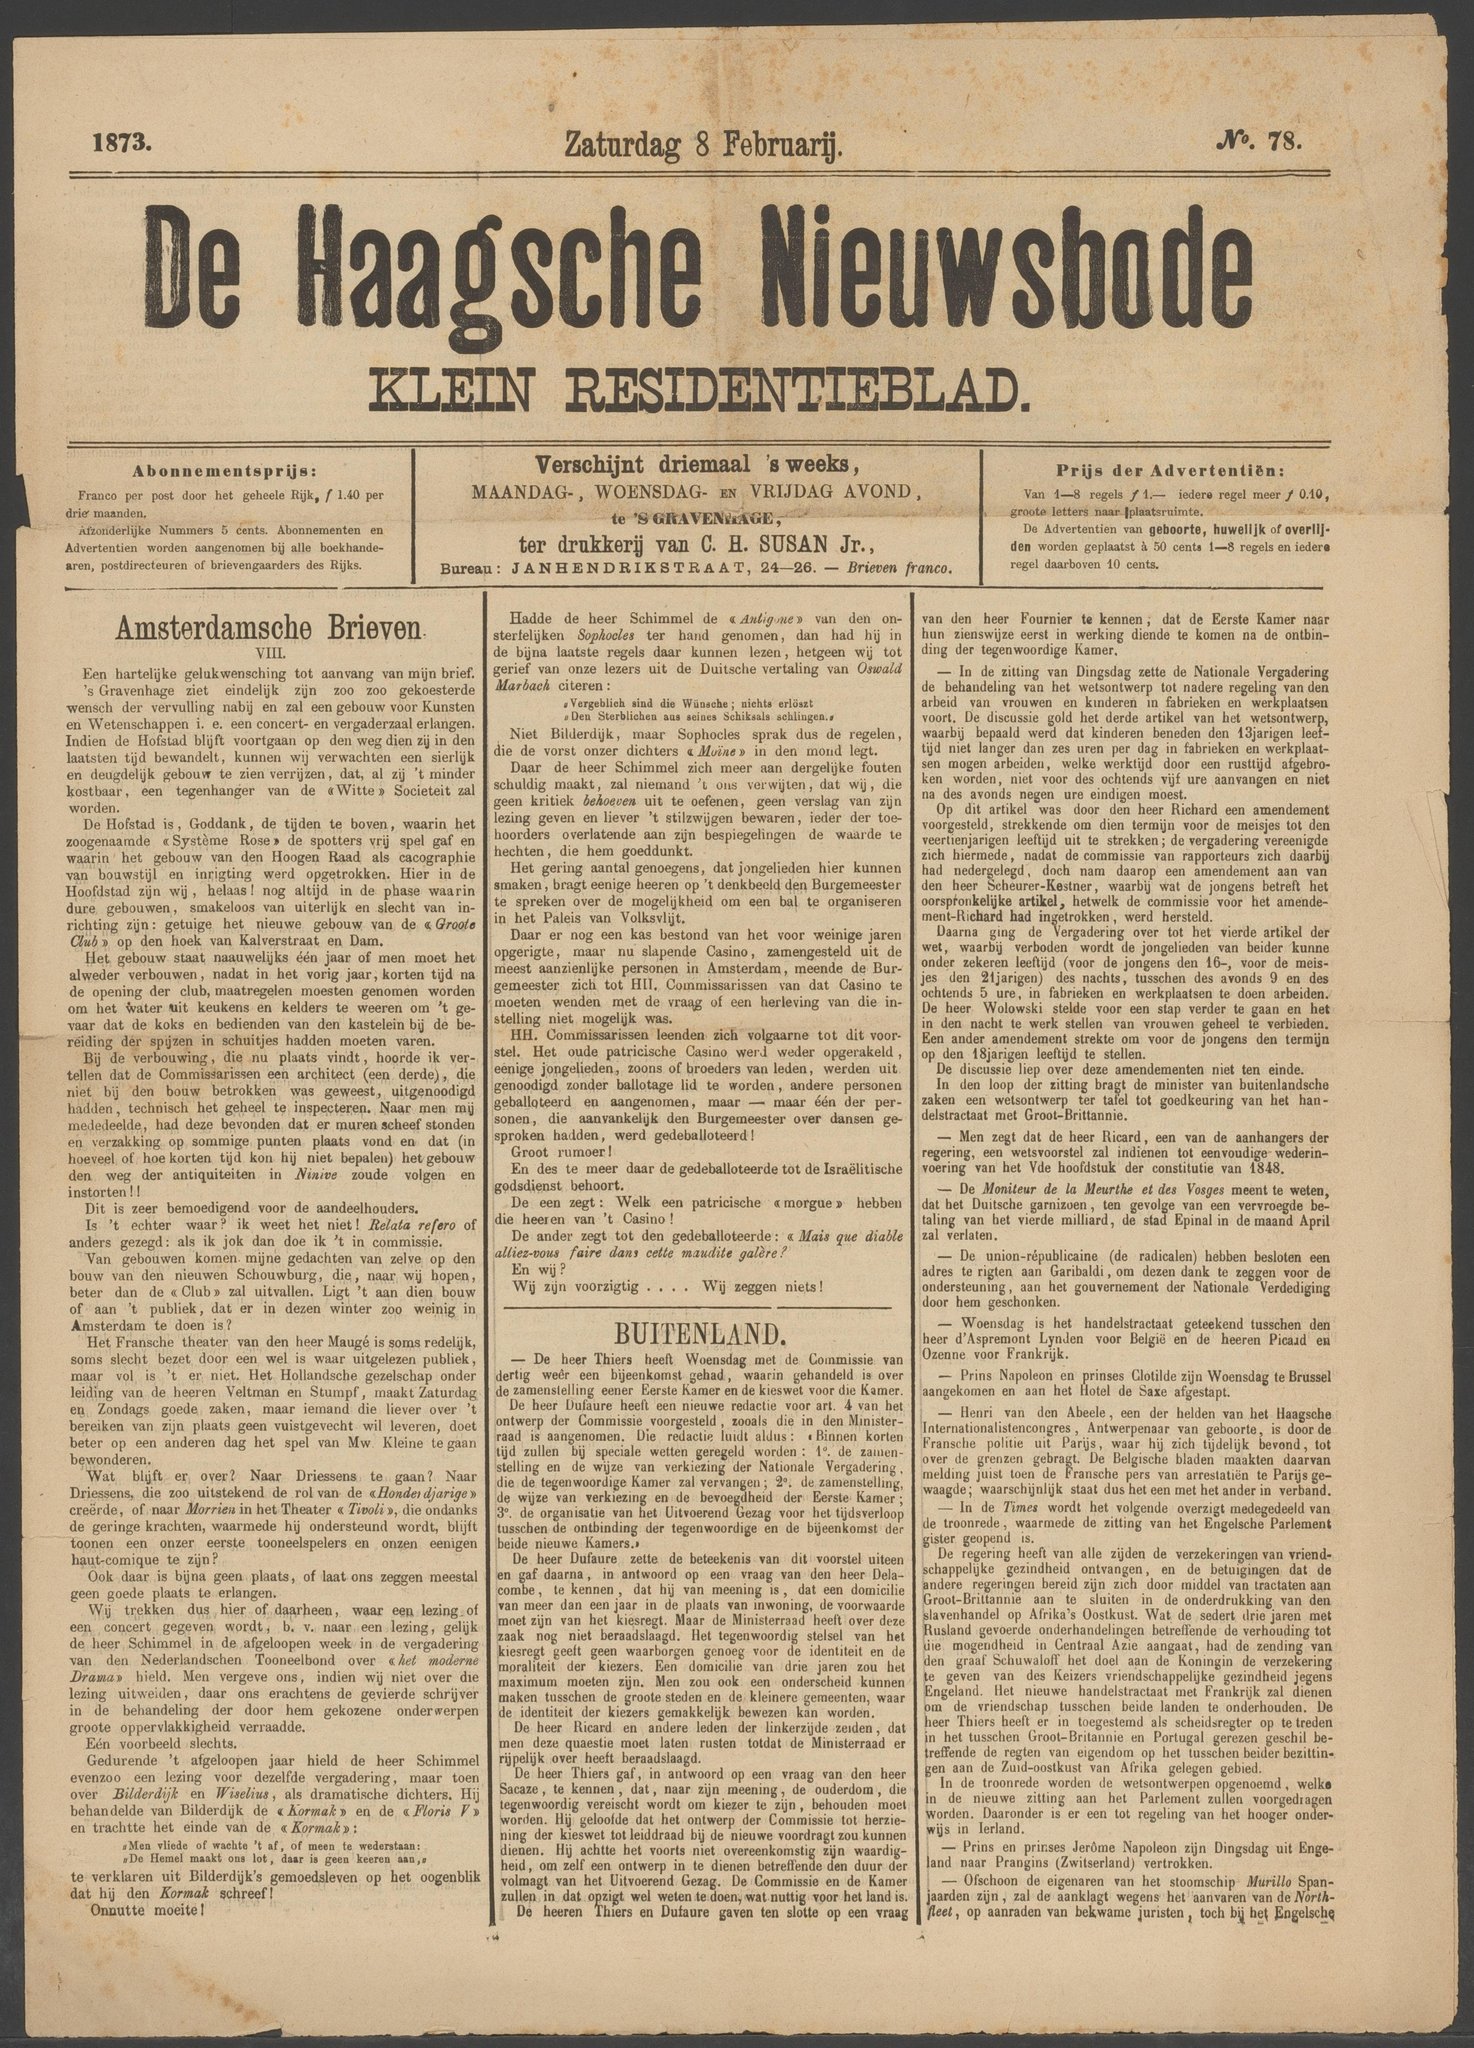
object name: newspaper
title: De Haagsche Nieuwsbode, 8 februari 1873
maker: c.h. susan jr.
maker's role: printer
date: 1873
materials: paper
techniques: letterpress printing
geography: the hague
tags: newspaper, news-sheet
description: Exemplaar van de krant 'De Haagsche Nieuwsbode. Klein Residentieblad', 8 februari 1873. Dubbelbladig, alle zijden bedrukt. Onderwerpsrubrieken binnen de Atlas Zeden en Gewoonten: Regeering, Officieele Nieuwsbladen.